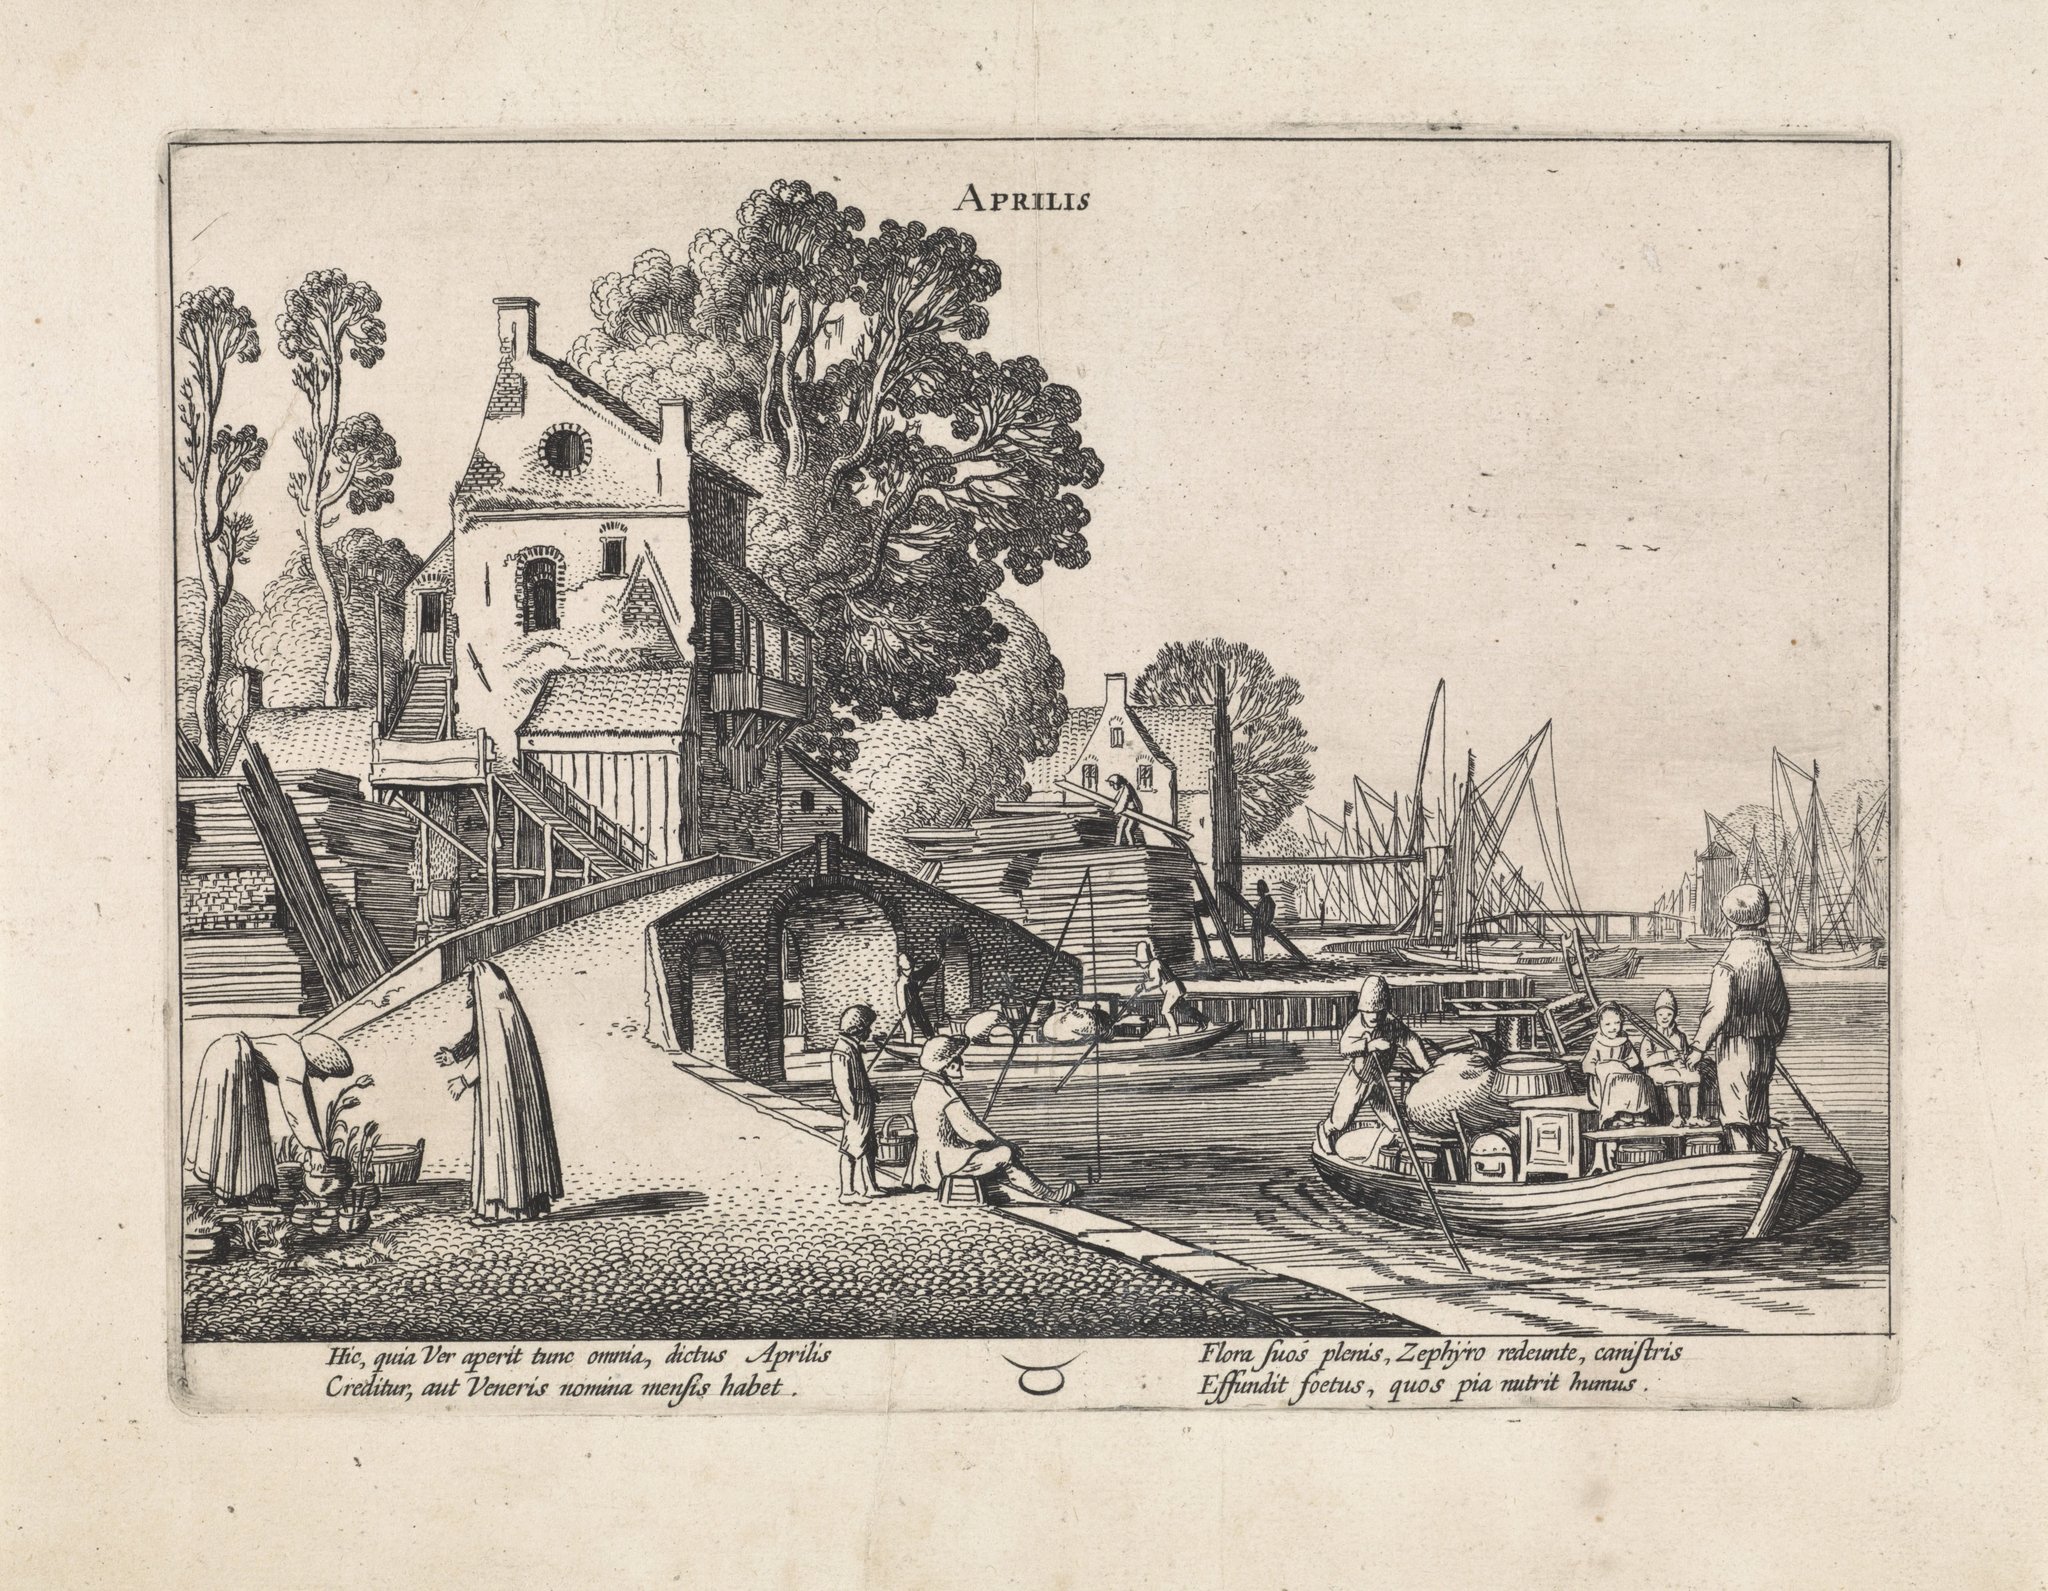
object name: print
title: Duodecim anni mensium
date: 1608-1618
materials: paper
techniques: etching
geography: northern netherlands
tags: landscape symbolizing april, taurus (zodiacal sign of april), traffic on the water, angling, bridge in village across river, canal, etc.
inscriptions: collector's mark: Lugt 964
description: Gezicht op een dorp met een stenen brug, waar op de kade en op het water veel bedrijvigheid is, voorstellende de maand april. Links een vrouw bij een bloemenverkoper, op de kade een visser en op het water een roeiboot met een echtpaar en veel huisraad. Onderaan het astrologische symbool van het sterrenbeeld stier. Prent uit een serie van twaalf.